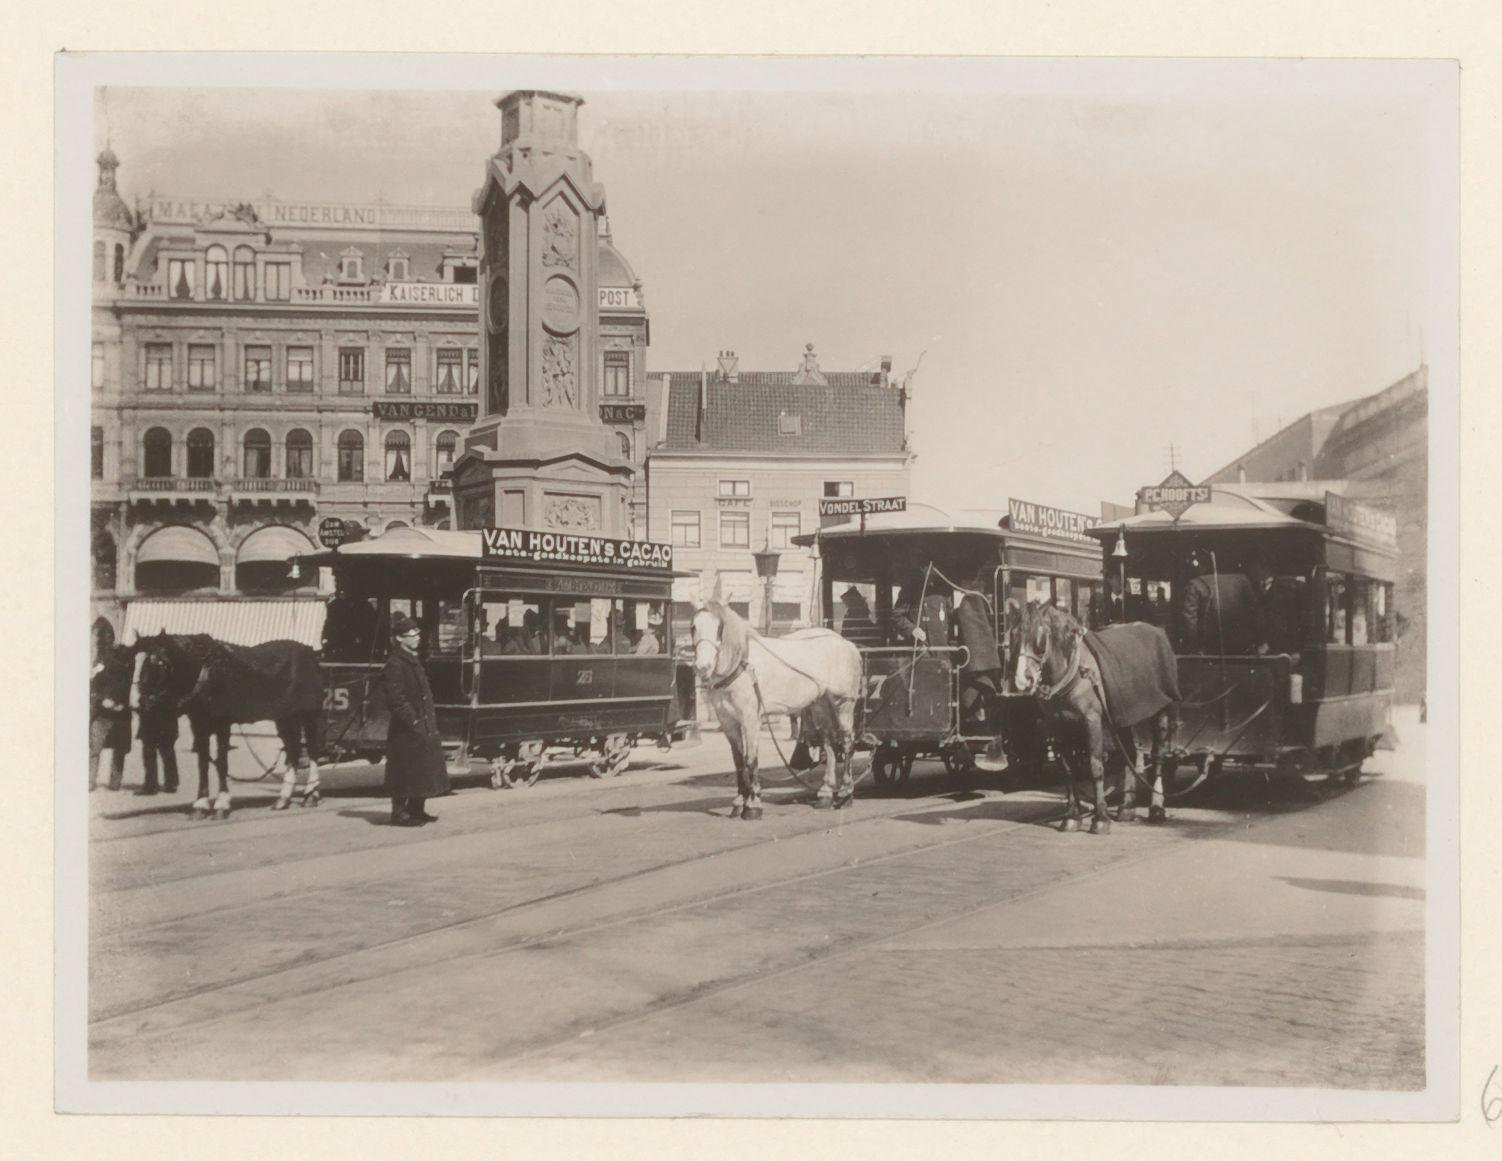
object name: photograph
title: Gezicht op de Dam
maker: Anonymous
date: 1900-1950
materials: paper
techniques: gelatin silver print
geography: amsterdam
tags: square, place, circus, etc., diligence, omnibus, horse-tram, city-view in general; 'veduta'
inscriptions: collector's mark: ‘7’ Lugt 1641b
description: Onderwerpsrubriek binnen de Atlas Amsterdam: Dam (na 1835).